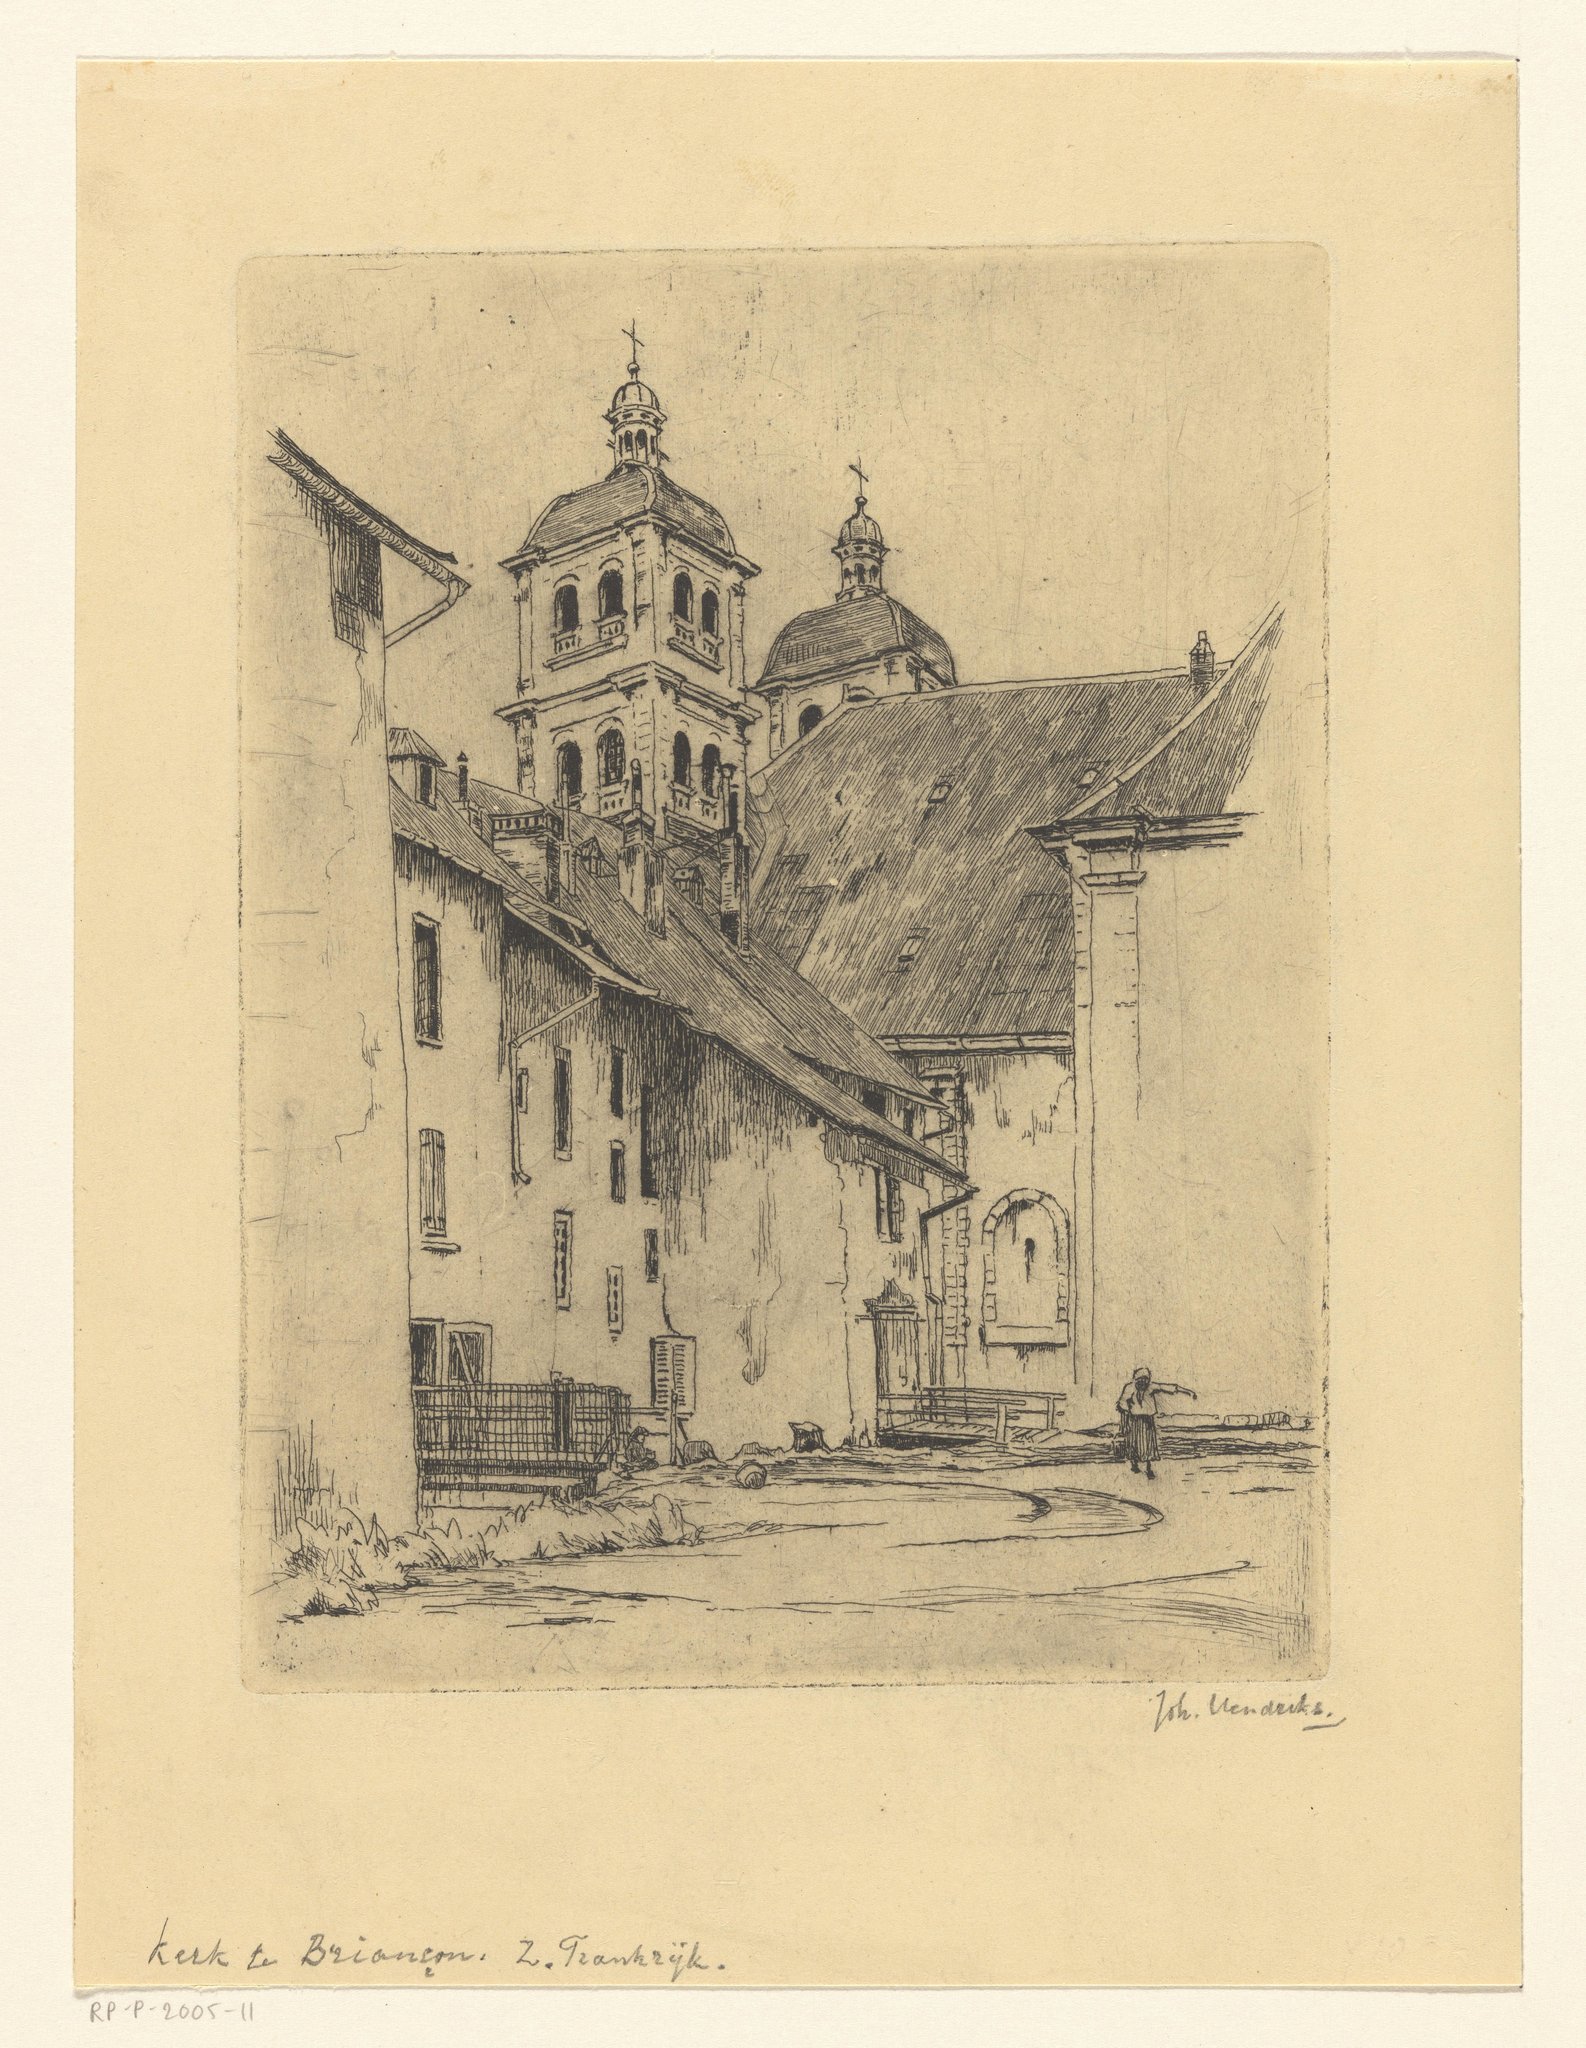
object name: print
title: Kerk te Briançon, Zuid-Frankrijk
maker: johannes henrichs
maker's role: print maker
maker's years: 1882-1954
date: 1892-1954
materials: paper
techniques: etching, intaglio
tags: church (exterior), street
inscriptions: collector's mark: Lugt 2760, collector's mark: Lugt 2228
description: De kathedraal van Briançon en omliggende gebouwen.